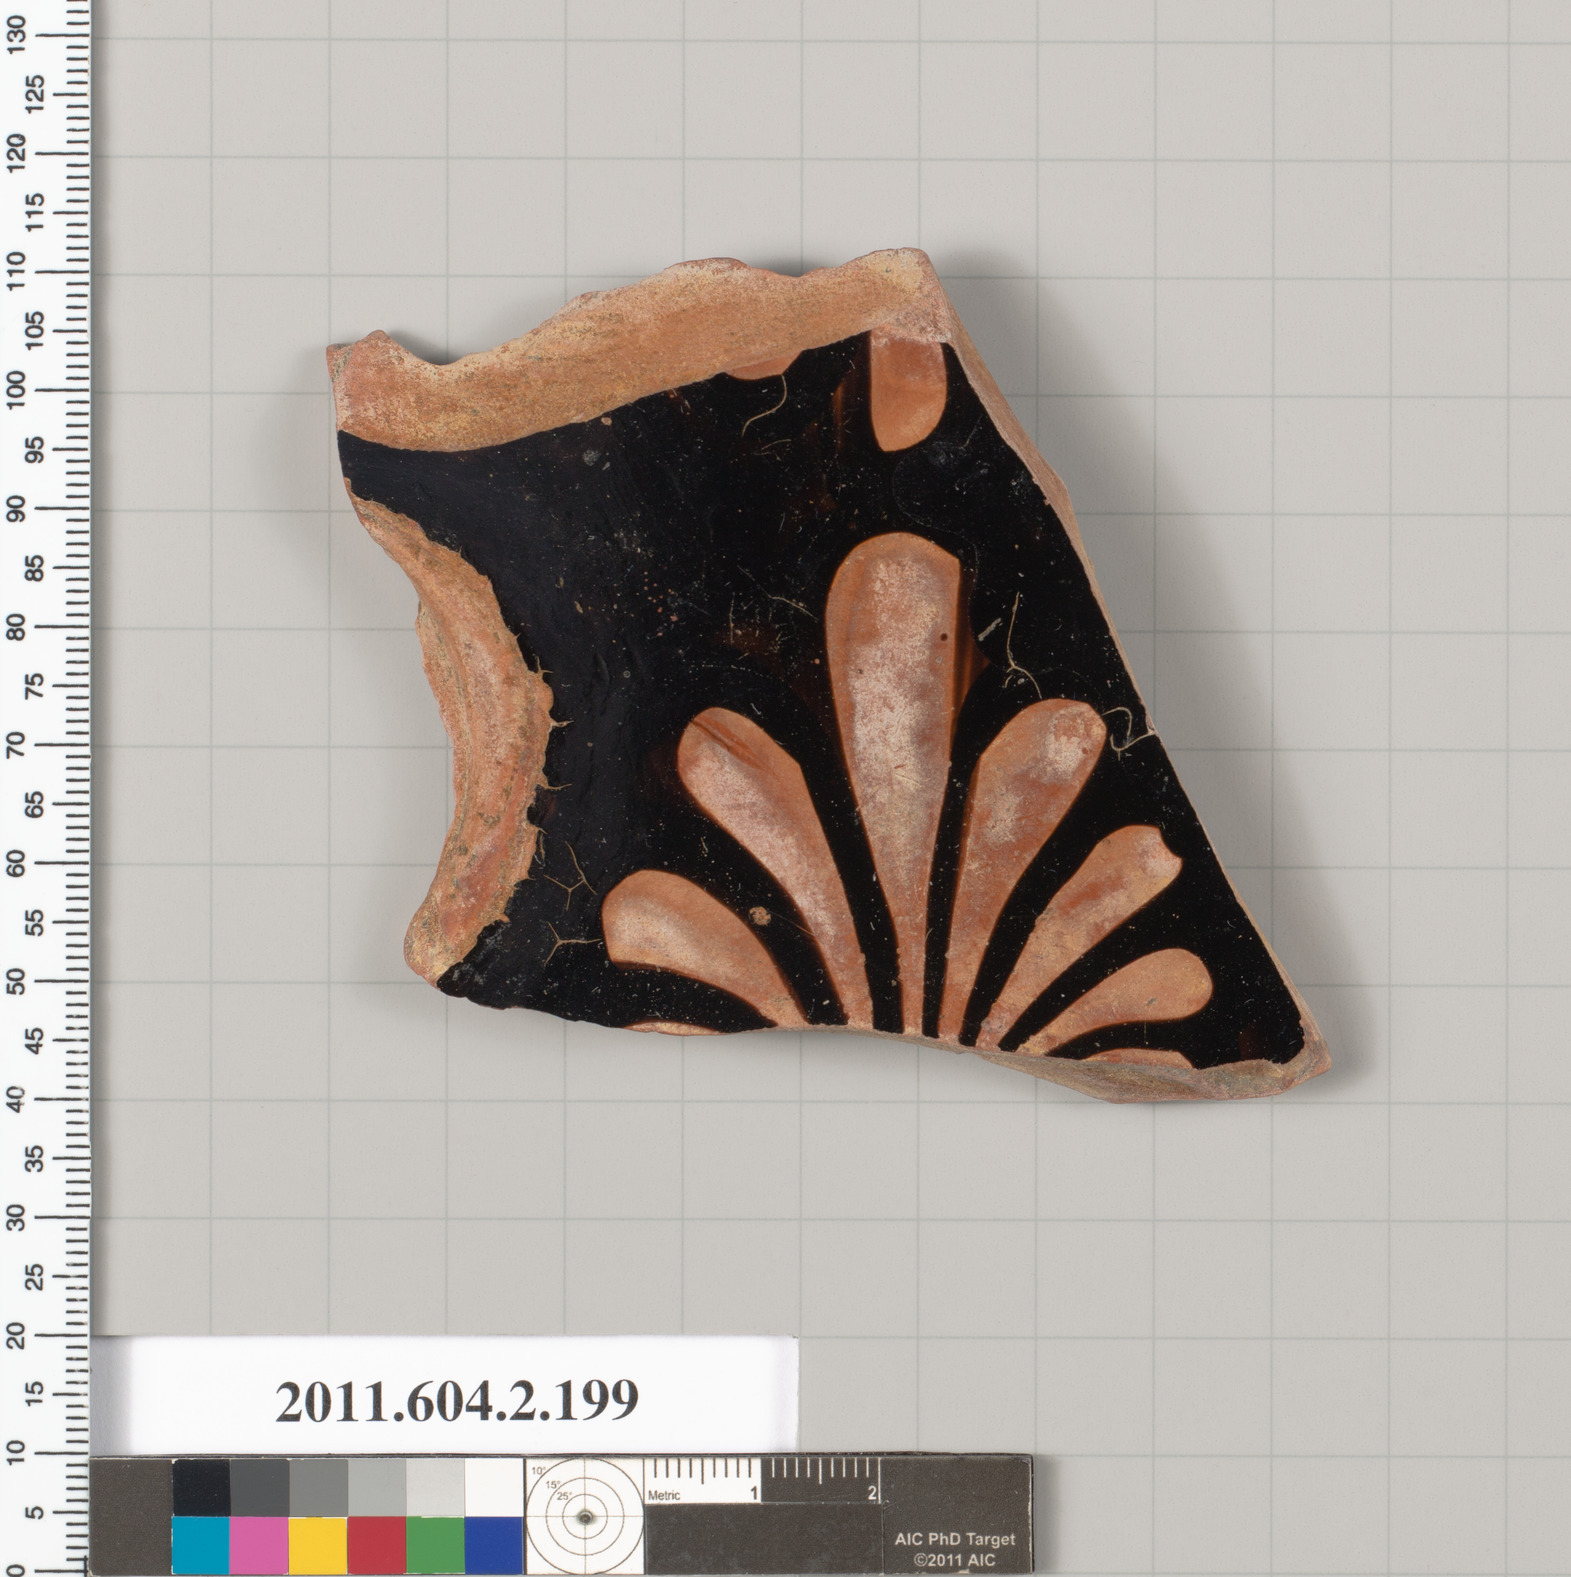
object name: stamnos fragment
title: Terracotta fragment of a stamnos (jar)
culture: greek, attic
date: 520-490 BCE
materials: terracotta